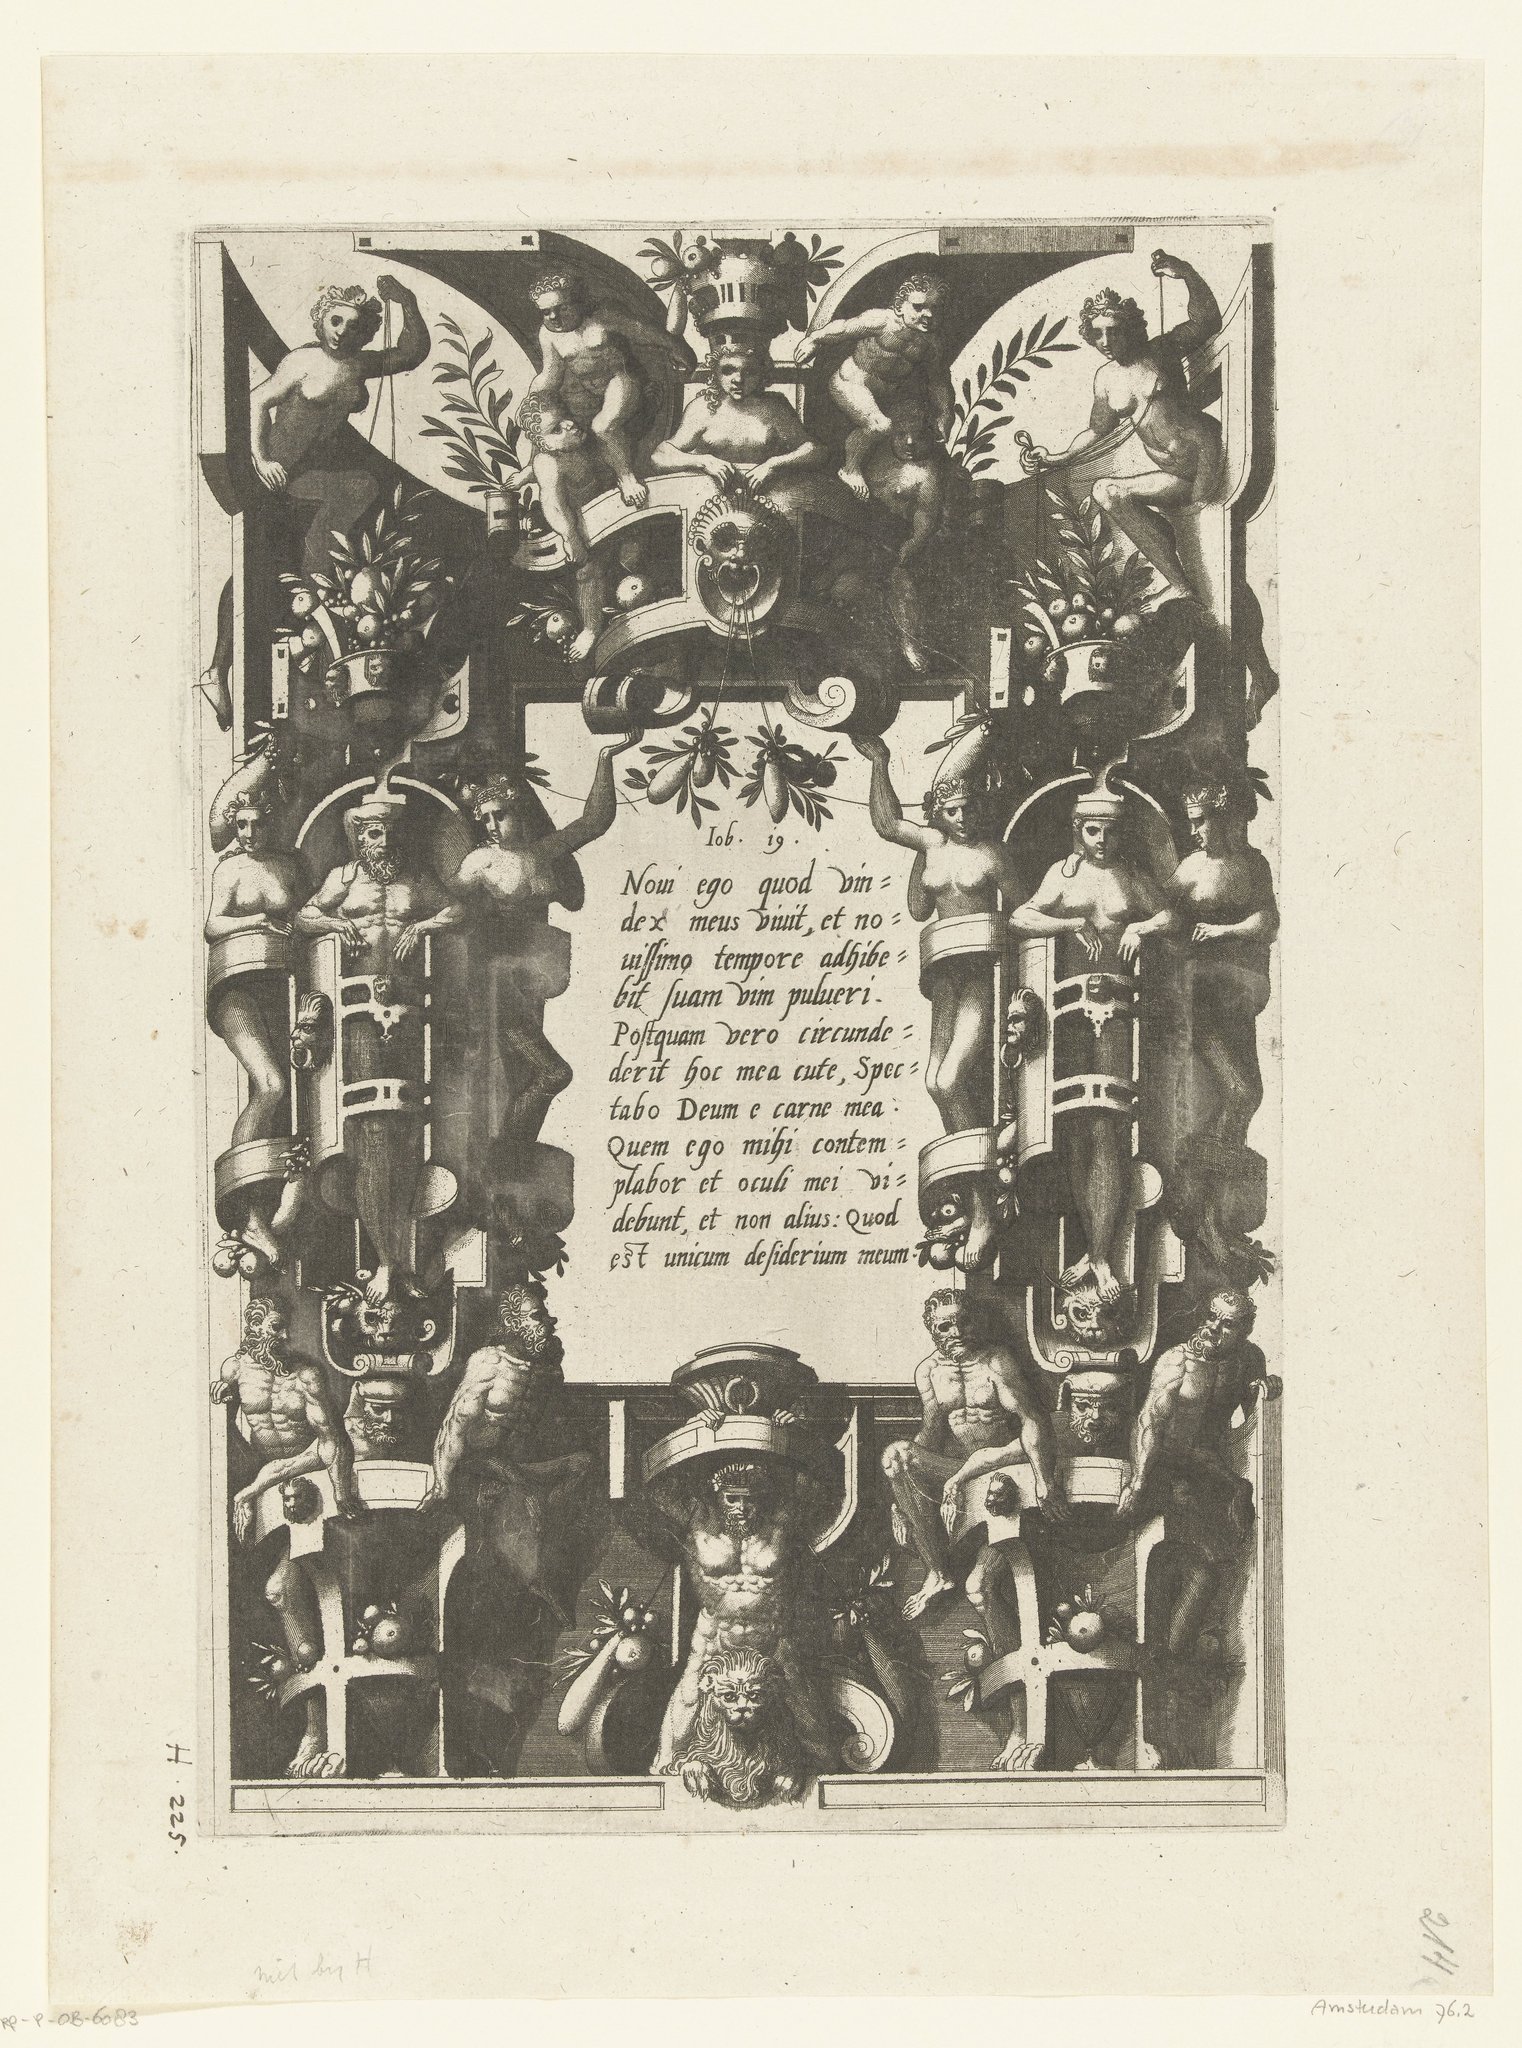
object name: print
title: Vlakdecoraties en grafmonumenten / Veelderleij niewe inventien (...)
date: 1557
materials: paper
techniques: etching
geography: netherlands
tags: ornaments ~ art, scrollwork, strapwork ~ ornament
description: Cartouche in een omlijsting van rolwerk waarin vrouwen,mannen en kinderen. Middenonder een man zittend op een leeuw. Bovenaan een vrouw met stedekroon op het hoofd. In het midden in wit kader de tekst: Iob 19. Novi ego quod vin/ dex meus vivit...Quod / est unicum desiderium meum. Hoort bij serie bestaande uit een titelblad, een tekstblad en 14 bladen met grotesken met rolwerk, saters, guirlandes, trofeeën, dieren en fantasiewezens.